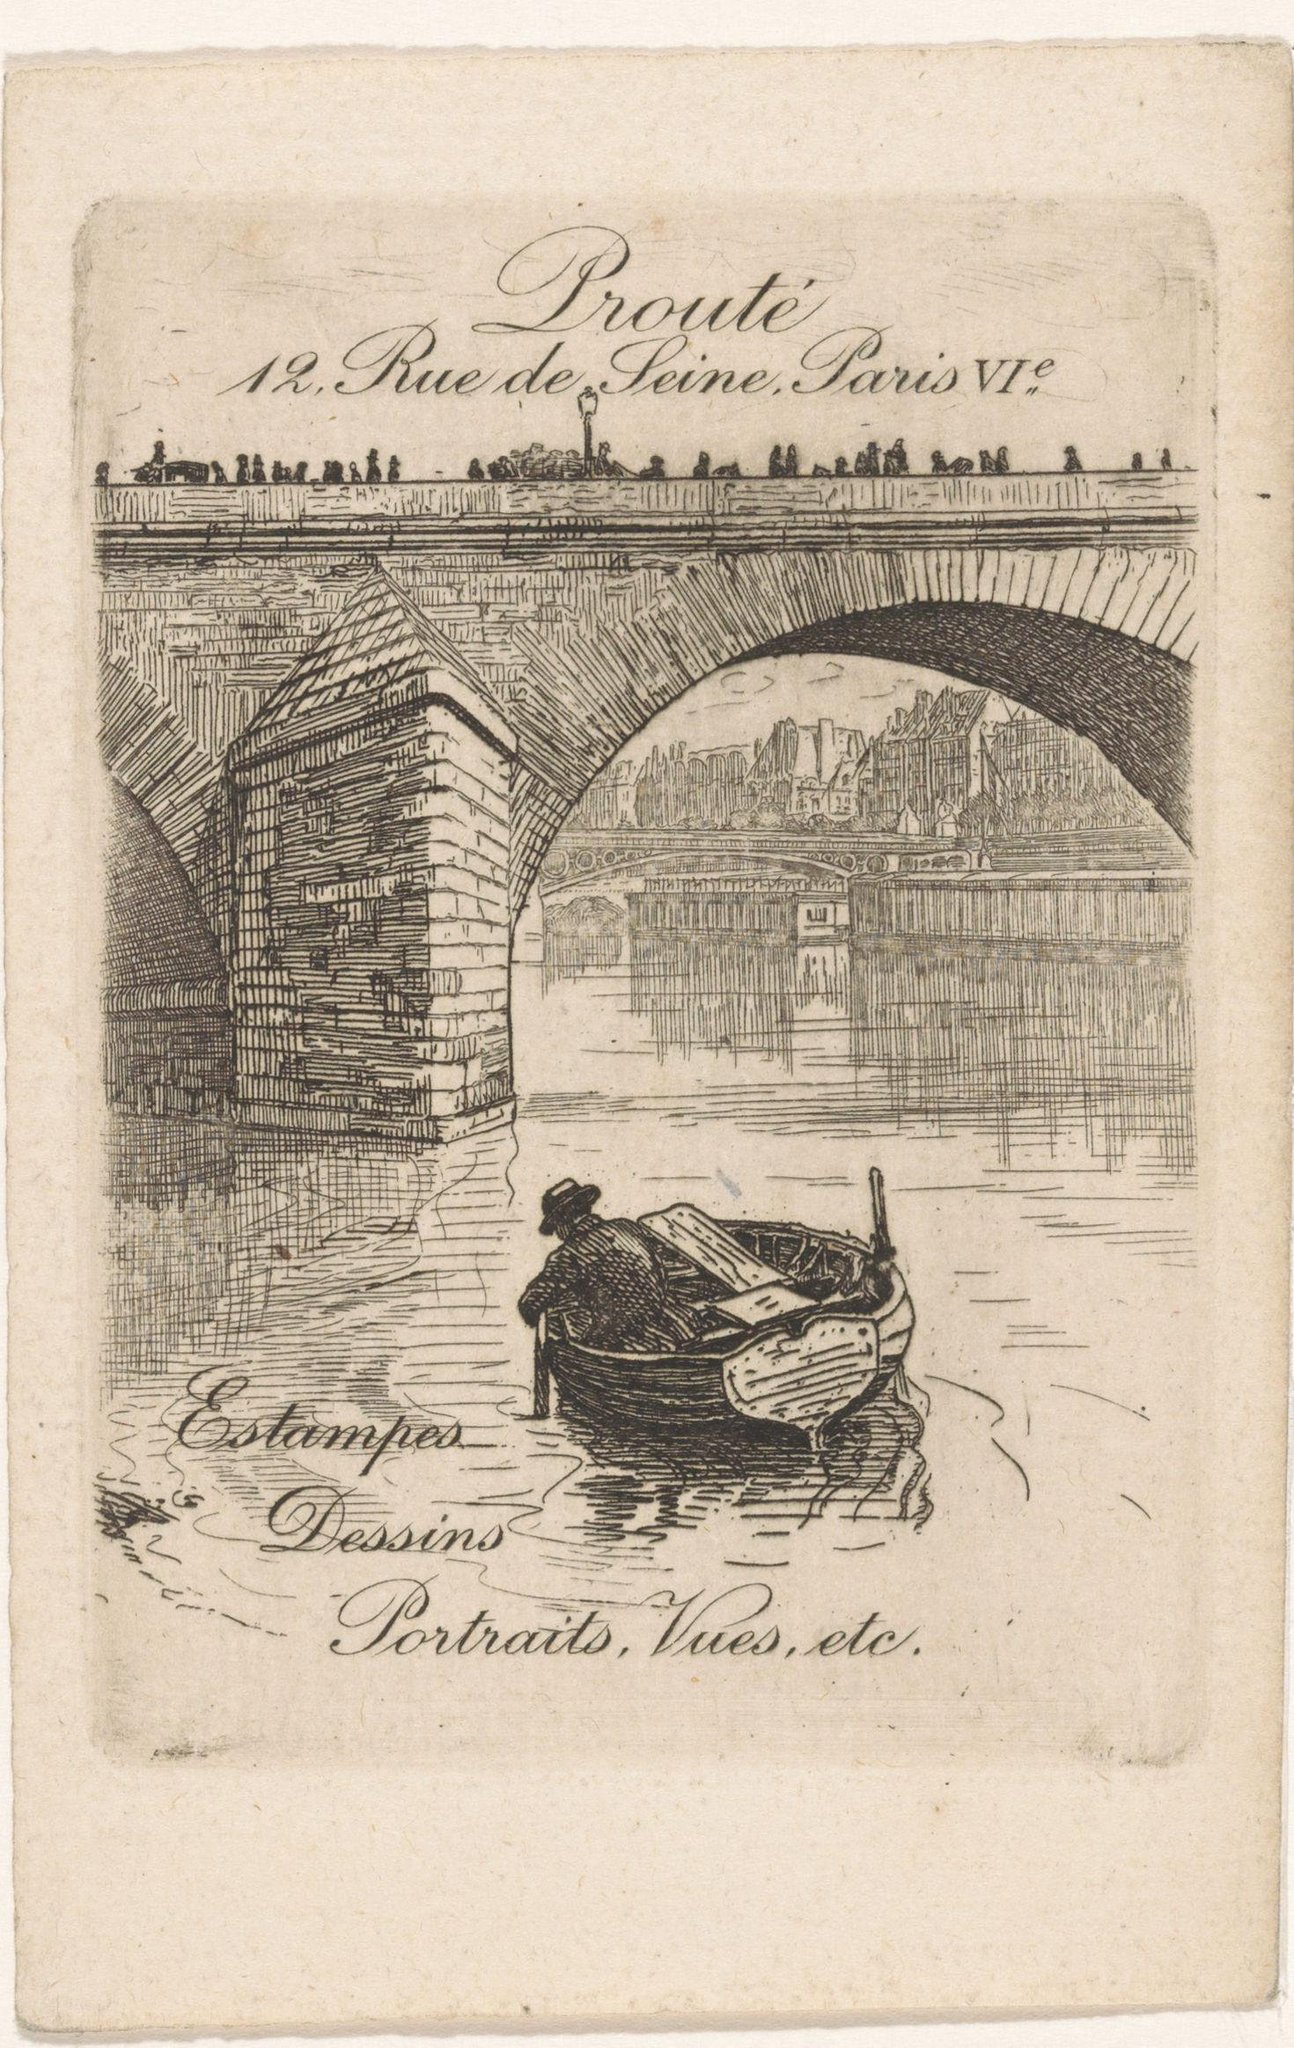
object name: visiting card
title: Visitekaartje van prenthandelaar Victor Prouté te Parijs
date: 1876-1917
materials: paper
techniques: etching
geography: paris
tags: rowing-boat, canoe, etc., bridge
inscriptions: collector's mark: Lugt 2228, collector's mark: Lugt 4779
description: Een man in een bootje op de Seine voor de Pont Royal, de Pont du Caroussel in de achtergrond.